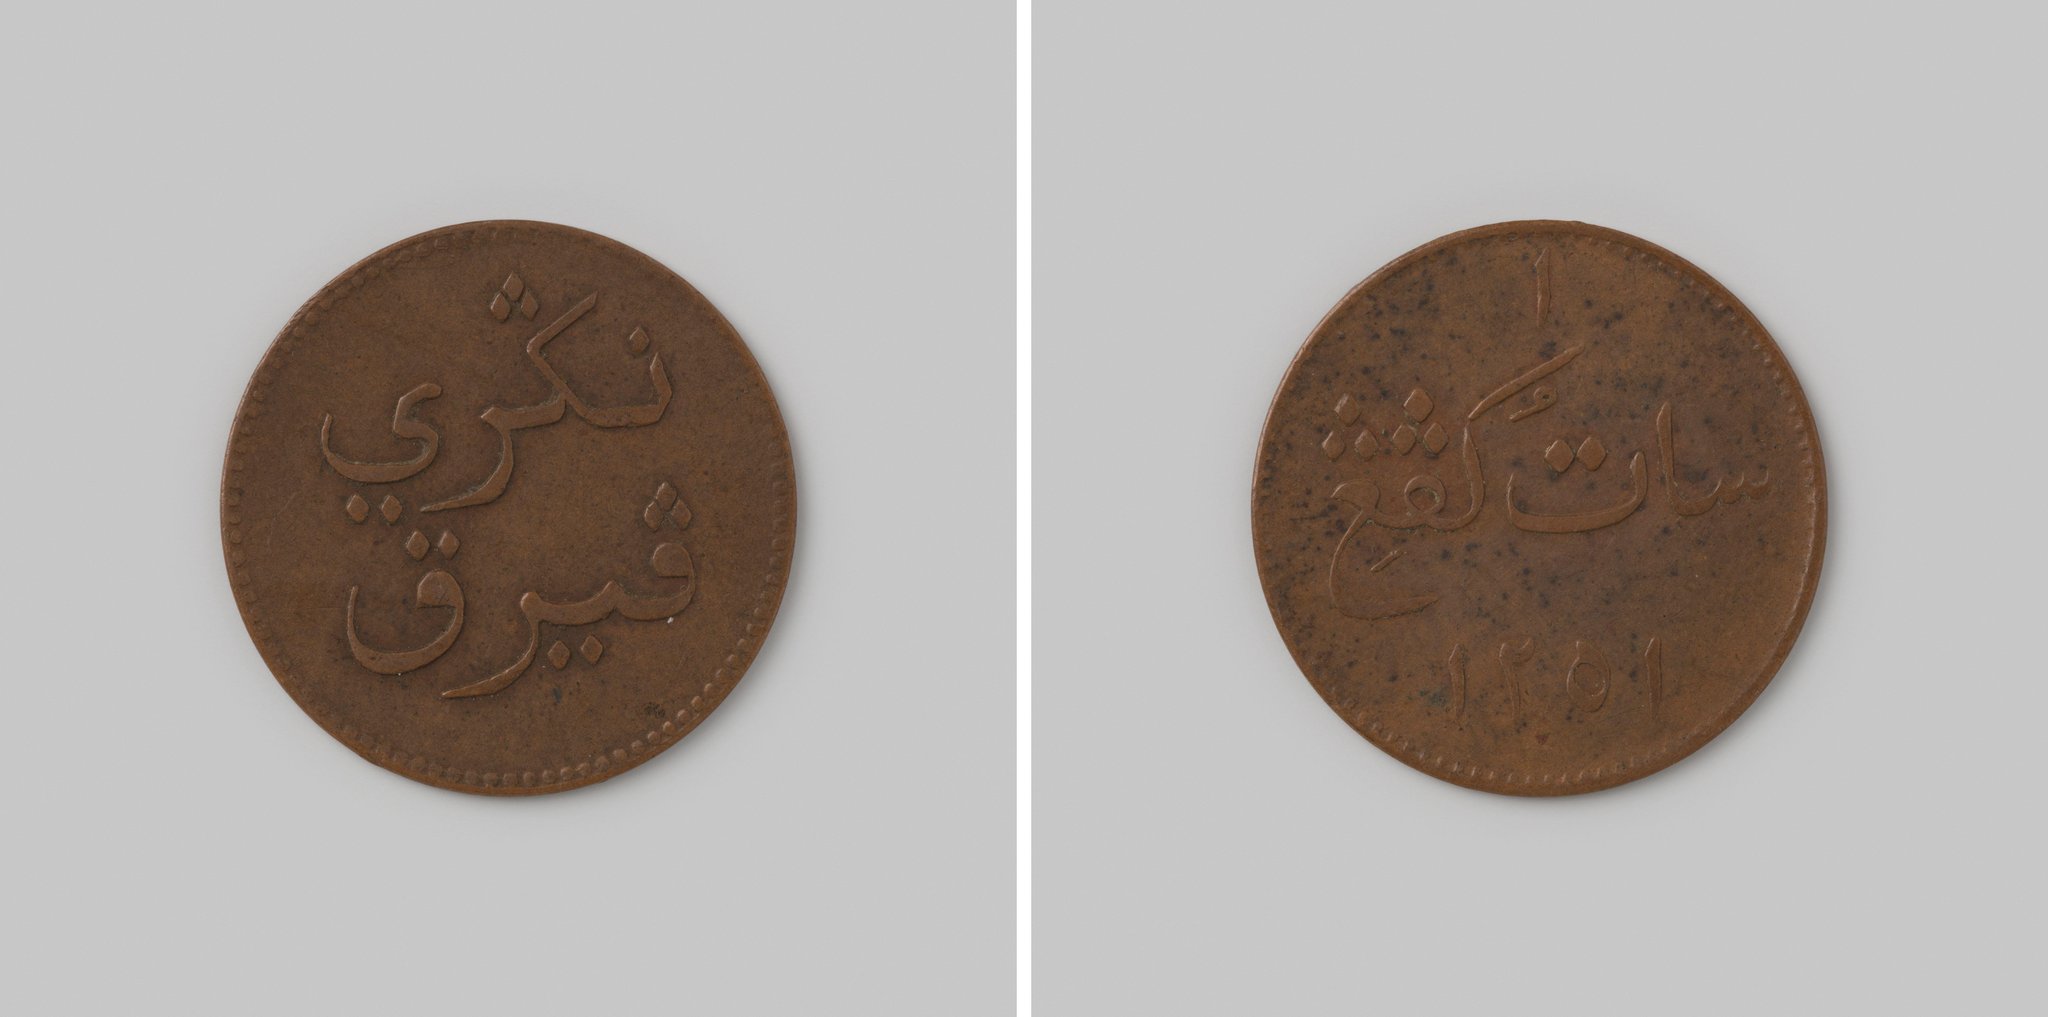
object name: coin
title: Kepeng uit Malakka voor Perak, 1251 [=1835]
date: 1835-1836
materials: copper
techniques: striking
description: Koperen particuliere munt. Voorzijde: in een regel waarde-aaanduiding sat kepeng in Arabische lettertekens, waarboven 1/1. Onderaan jaartal: 1251. Keerzijde: in twee regels lands-aanduiding Negri Perak in Arabische letttertekens. Gladde rand.